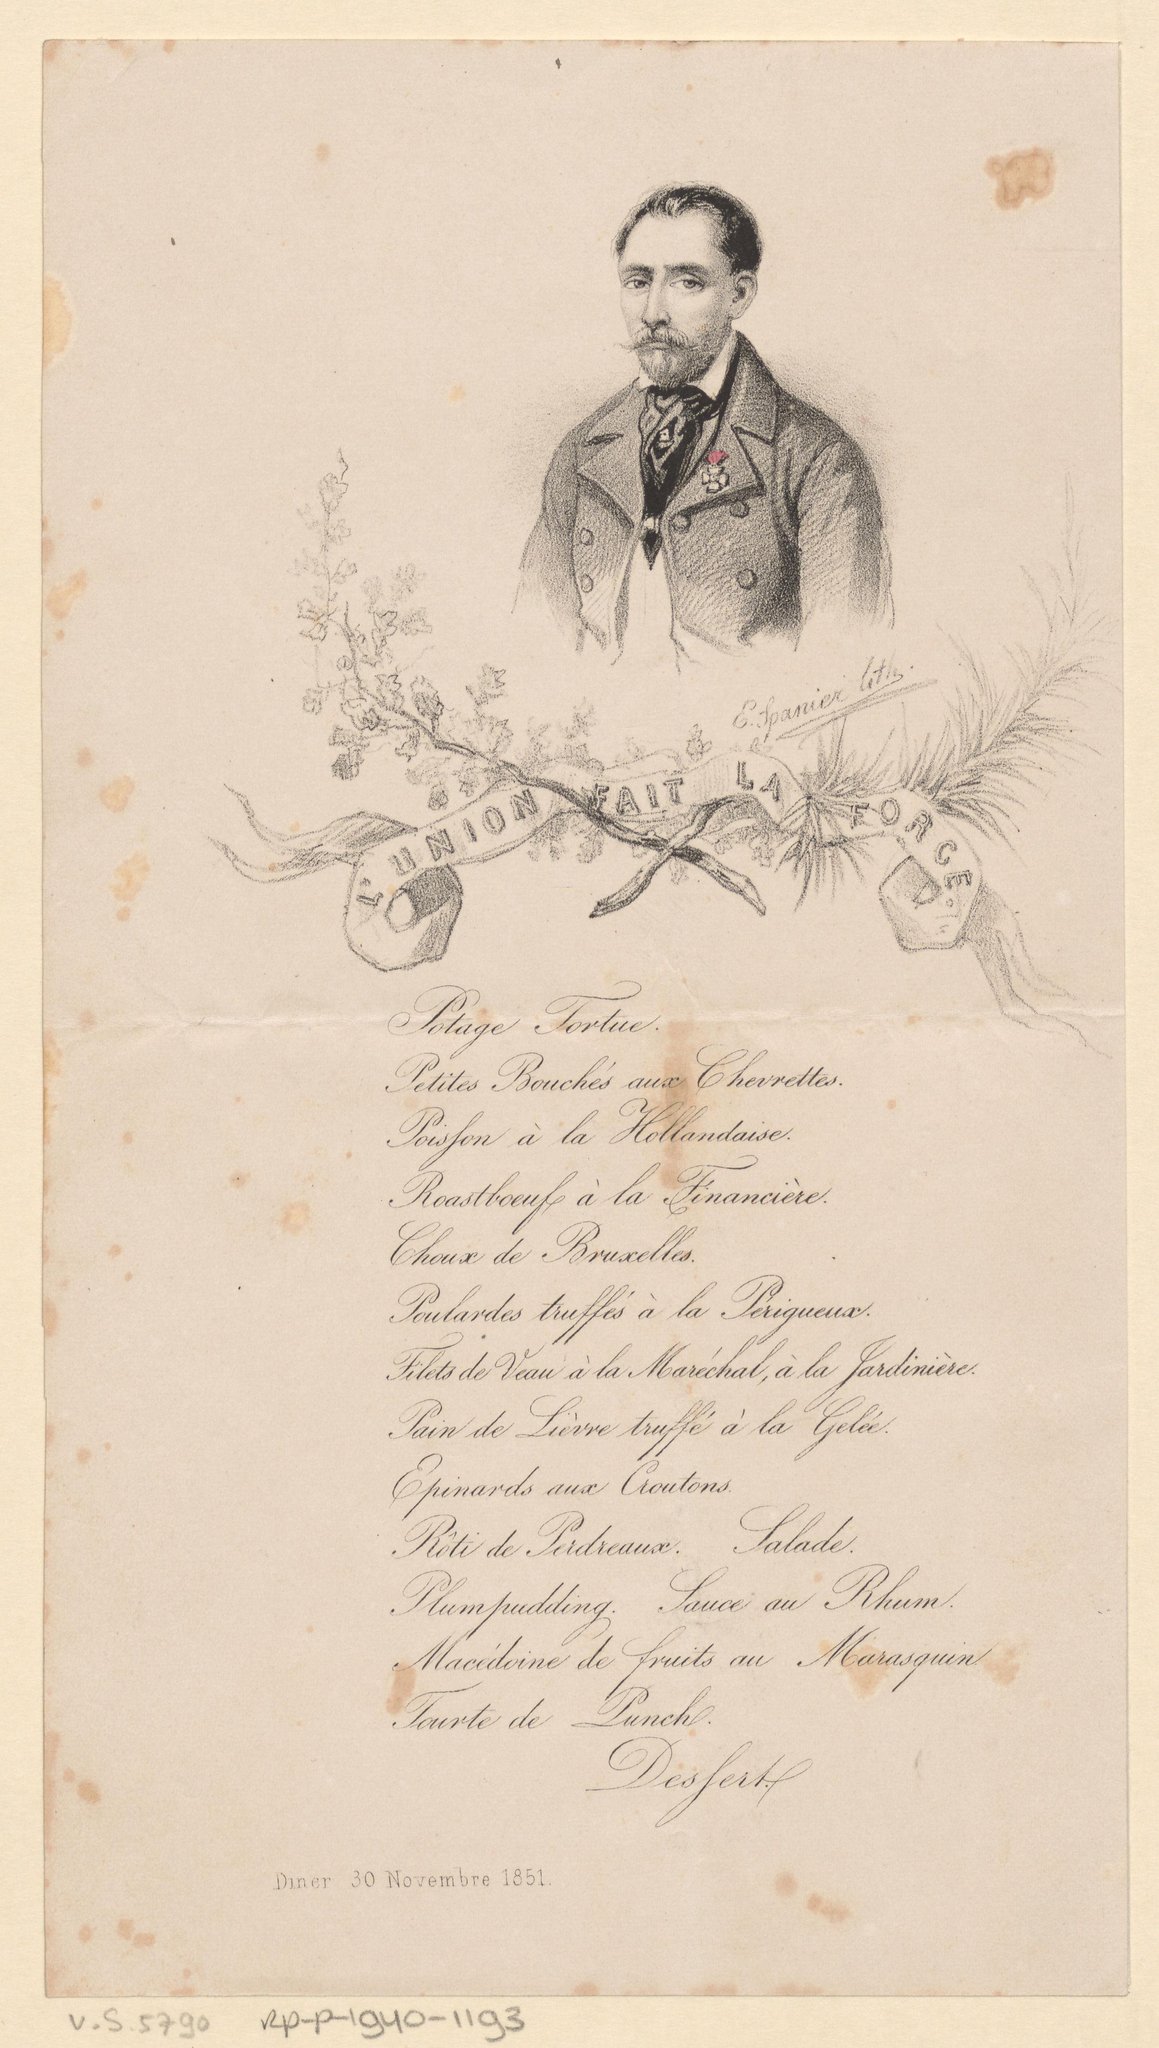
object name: print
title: Menu met Portret van Samuel Leonardus Verveer en de spreuk: "L'Union fait la force" ter gelegenheid van een diner op 30 november 1851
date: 1851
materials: paper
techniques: lithograph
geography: the hague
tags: the hague, salomon leonardus verveer, historical persons, portrait, self-portrait of painter, portrait, self-portrait of graphic artist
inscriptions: collector's mark: Lugt 2760, collector's mark: Lugt 2228